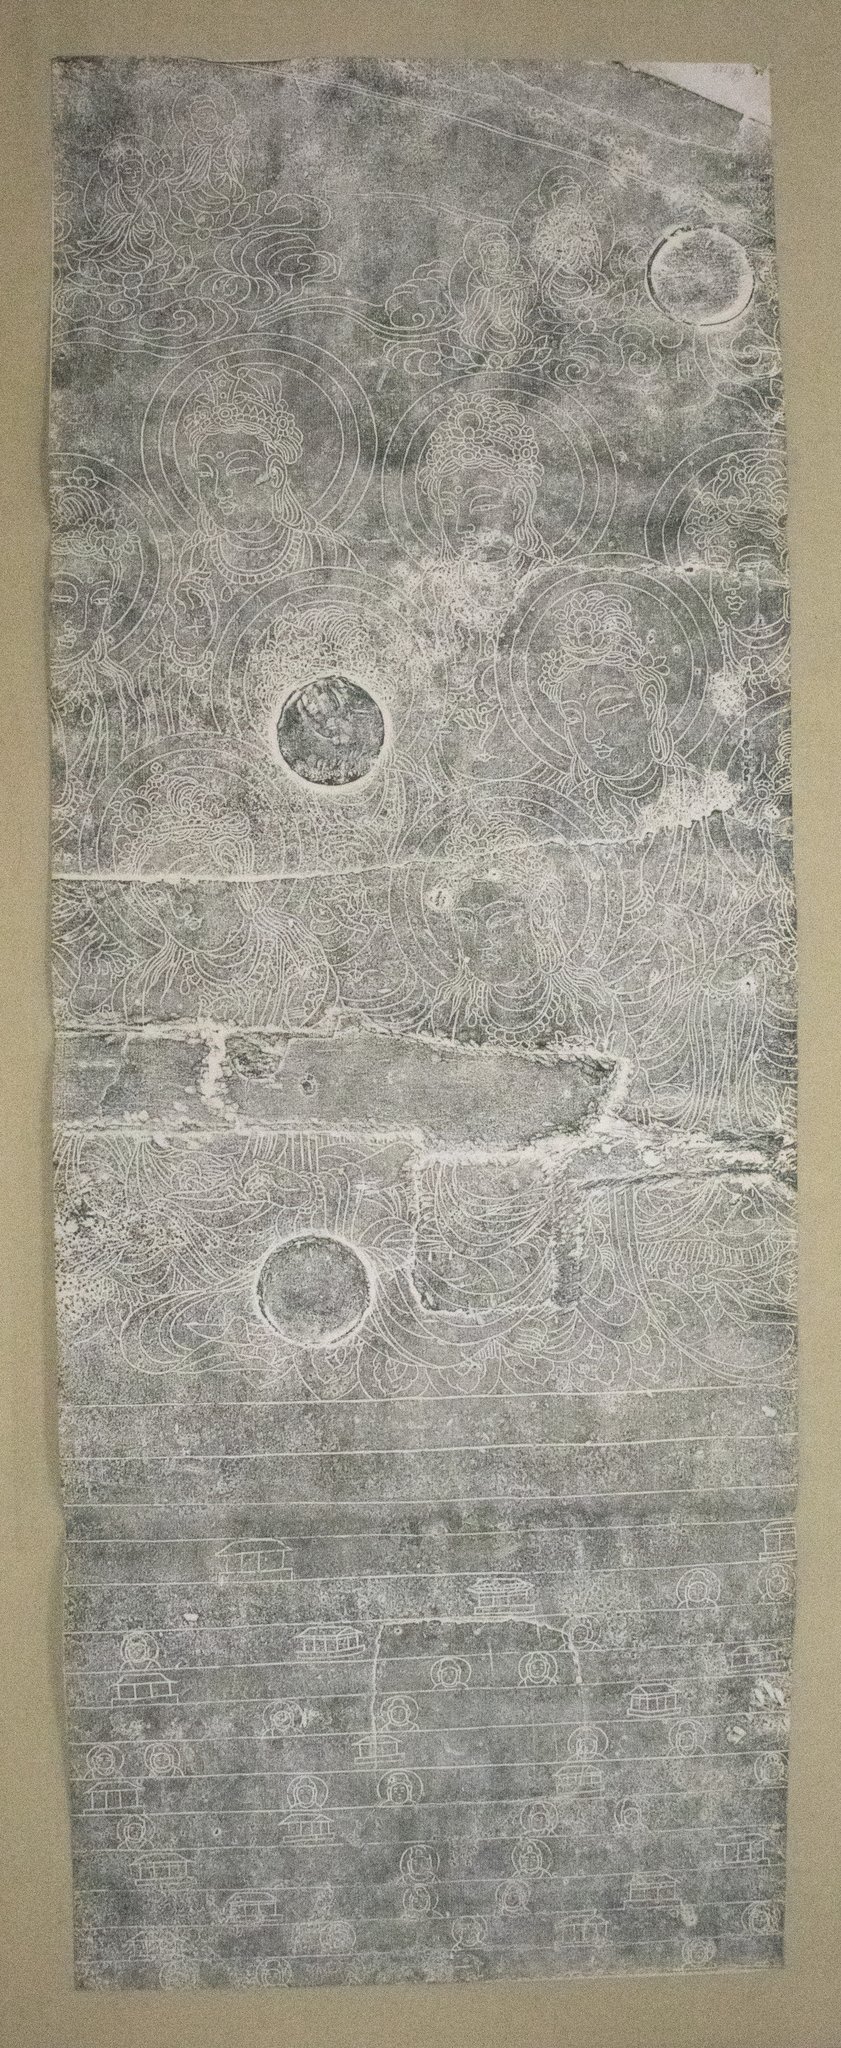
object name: rubbing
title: Rubbing from the Daibutsu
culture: japanese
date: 1901-2000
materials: ink, paper